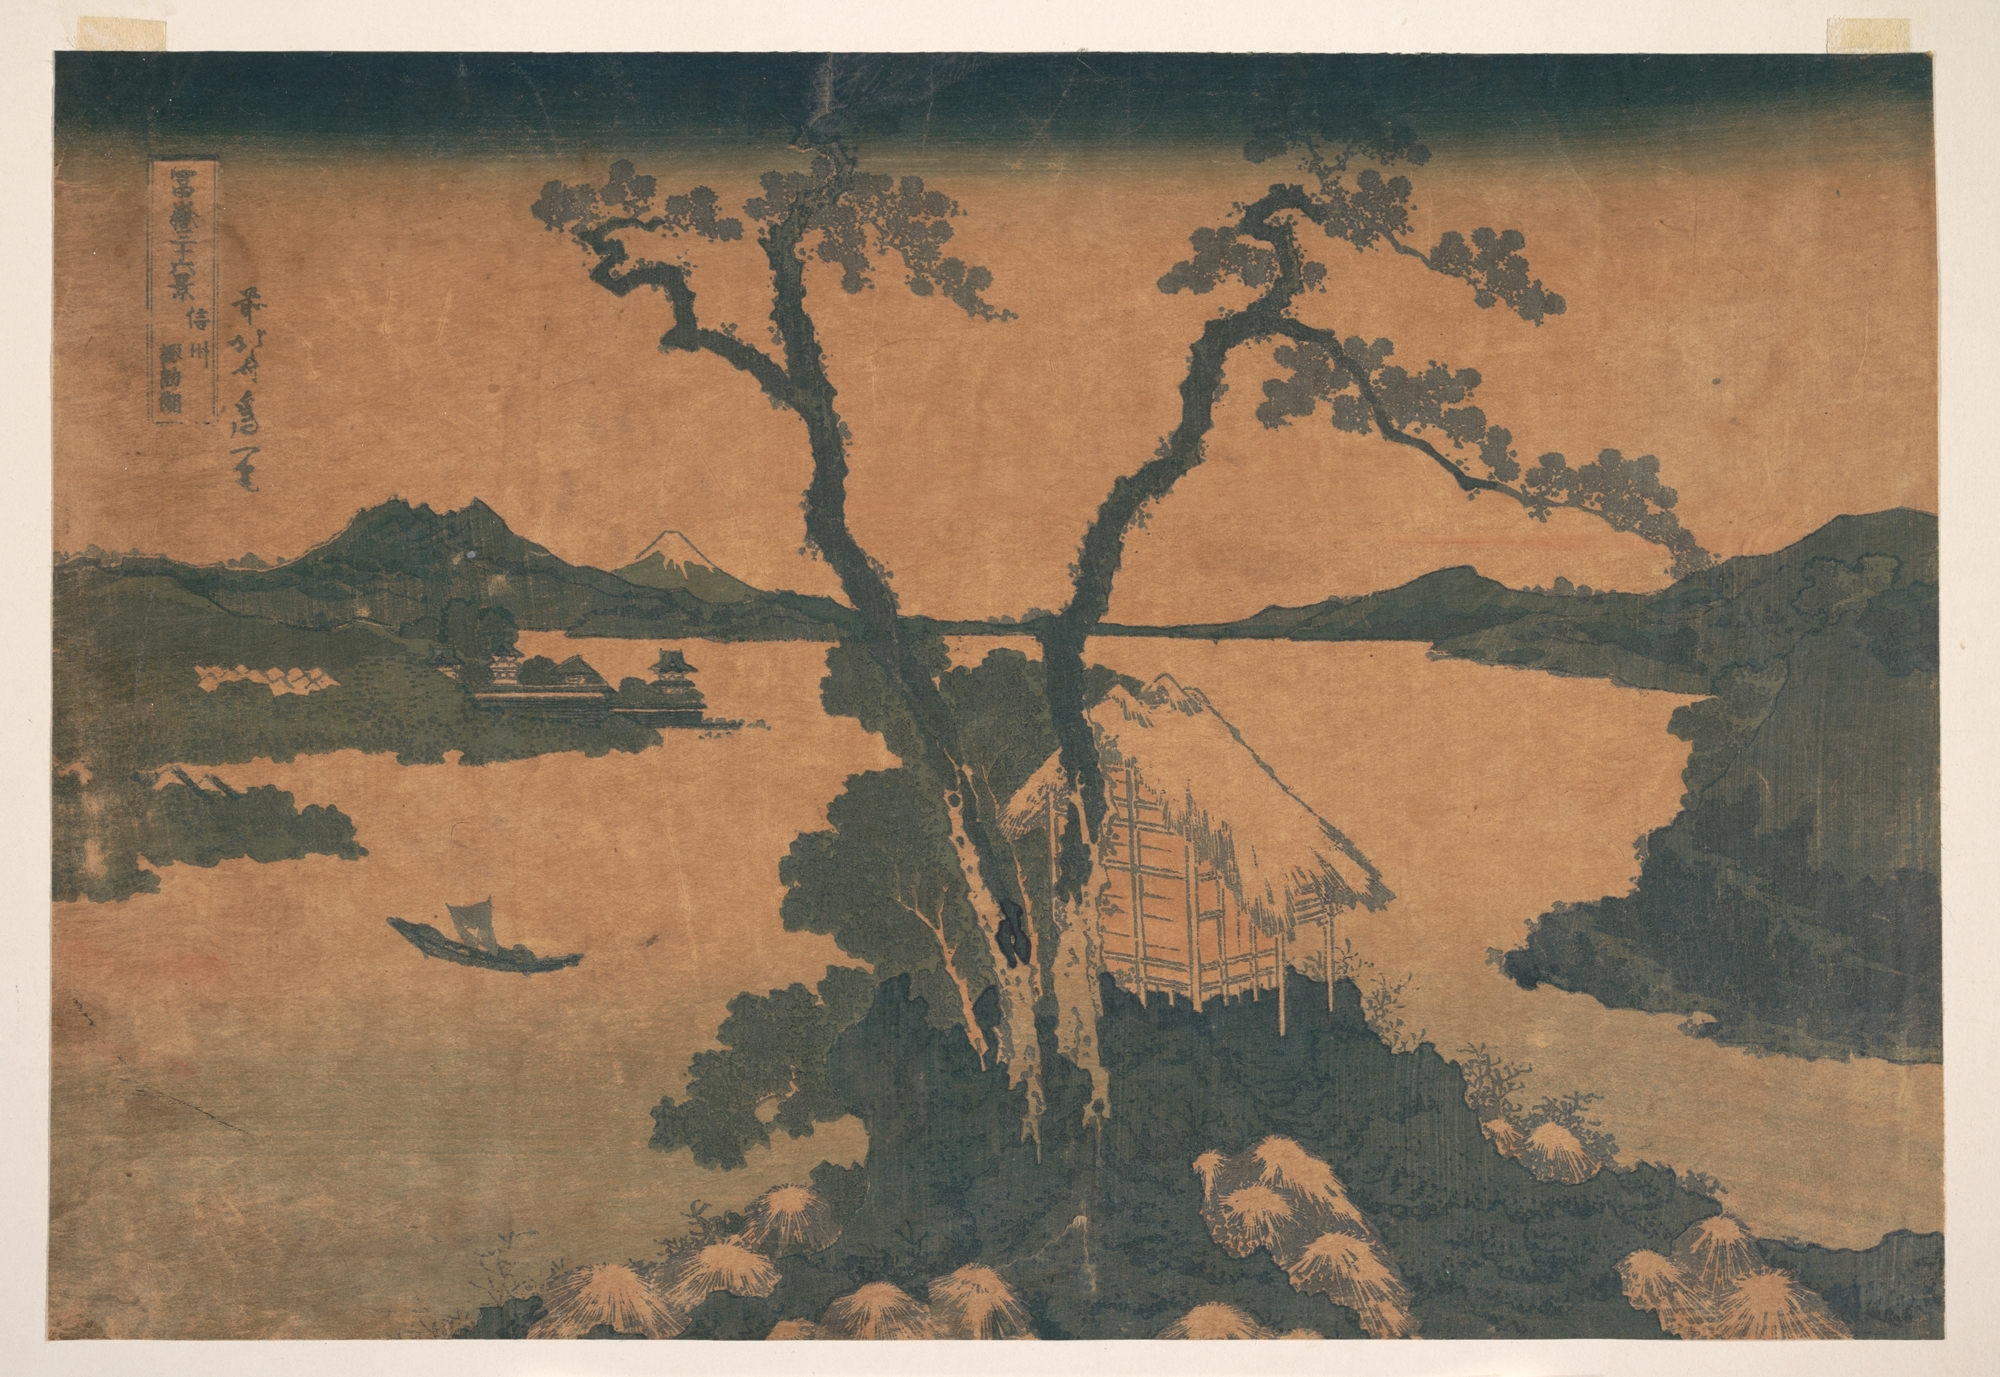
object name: woodblock print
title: Lake Suwa in Shinano Province (Shinshū Suwako), from the series Thirty-six Views of Mount Fuji (Fugaku sanjūrokkei)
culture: japanese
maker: katsushika hokusai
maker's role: artist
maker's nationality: japanese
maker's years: 1760-1849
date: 1830-1832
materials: ink, paper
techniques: woodblock print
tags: houses,lakes,trees,boats